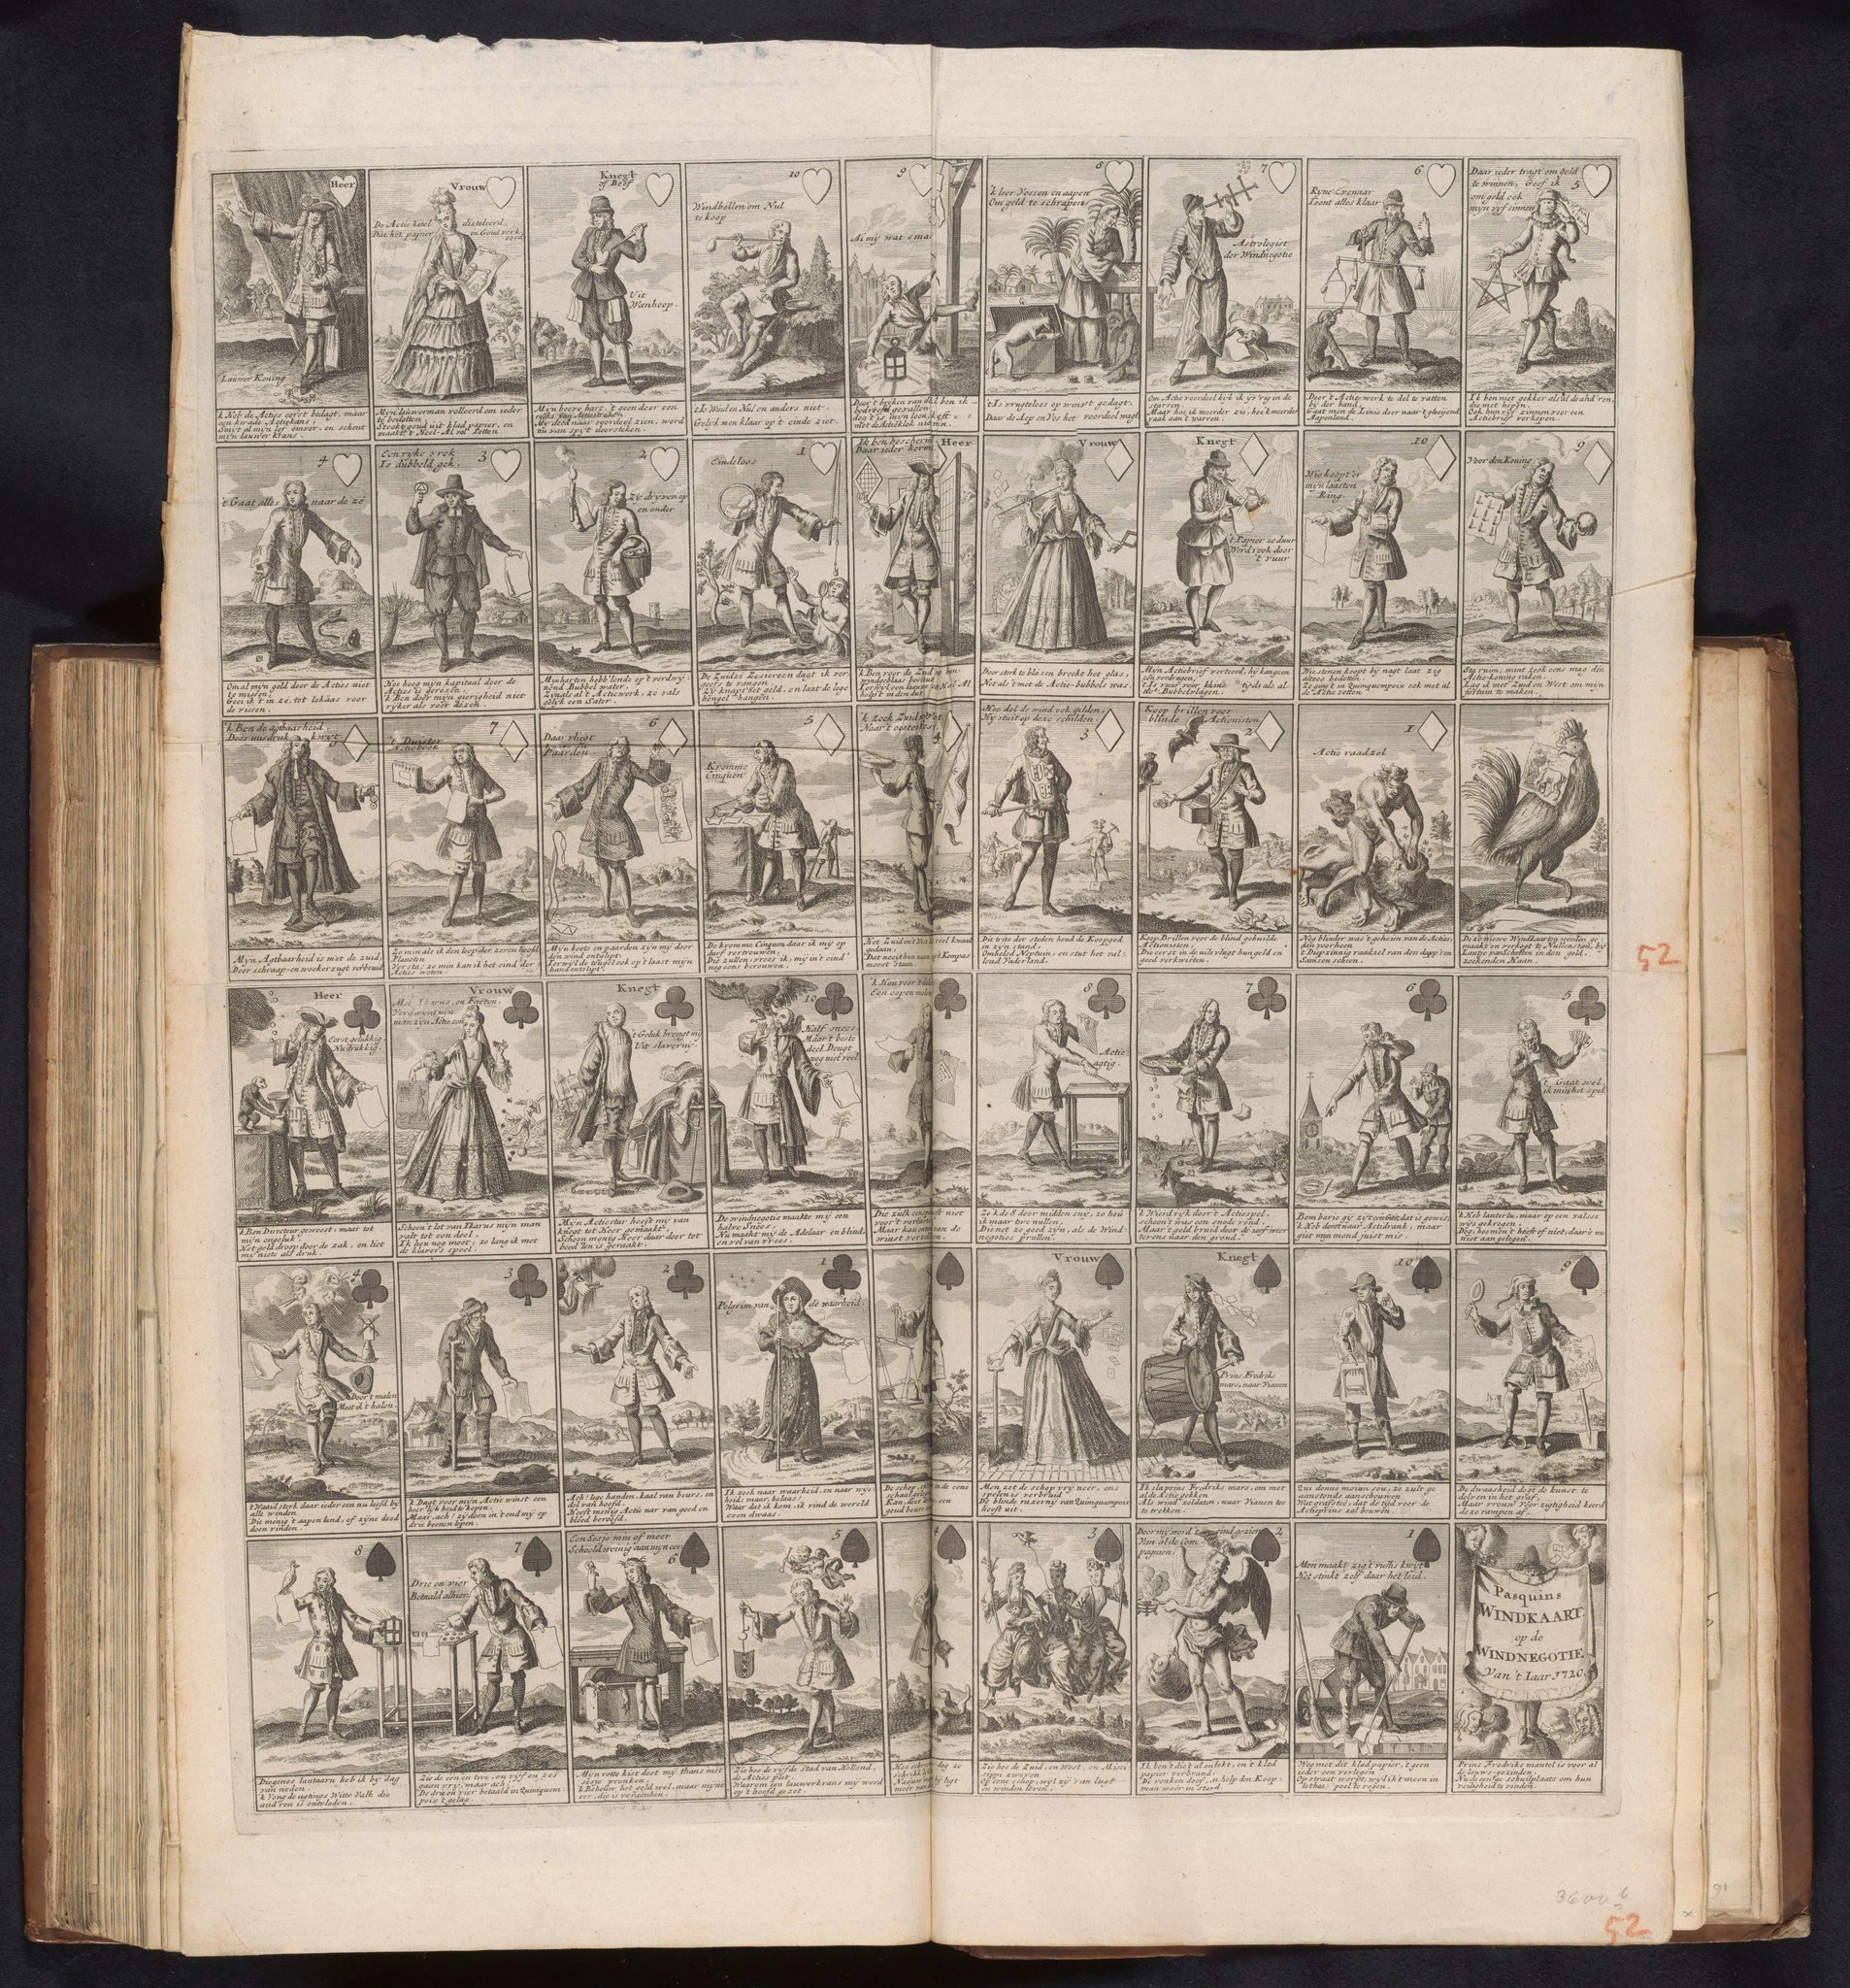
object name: cartoon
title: Pasquins Windkaart op de Windnegotie van 1720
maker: Anonymous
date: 1720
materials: paper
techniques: etching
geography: northern netherlands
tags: playing-cards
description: Pasquins Windkaart op de Windnegotie van 1720. Blad met een compleet spel van 52 speelkaarten, elke kaart met een voorstelling en versje gerelateerd aan de windhandel. Prent in de gebonden eerste uitgave (304 B 11) van Het Groote Tafereel der Dwaasheid met spotprenten op de Windhandel of Actiehandel van 1720.